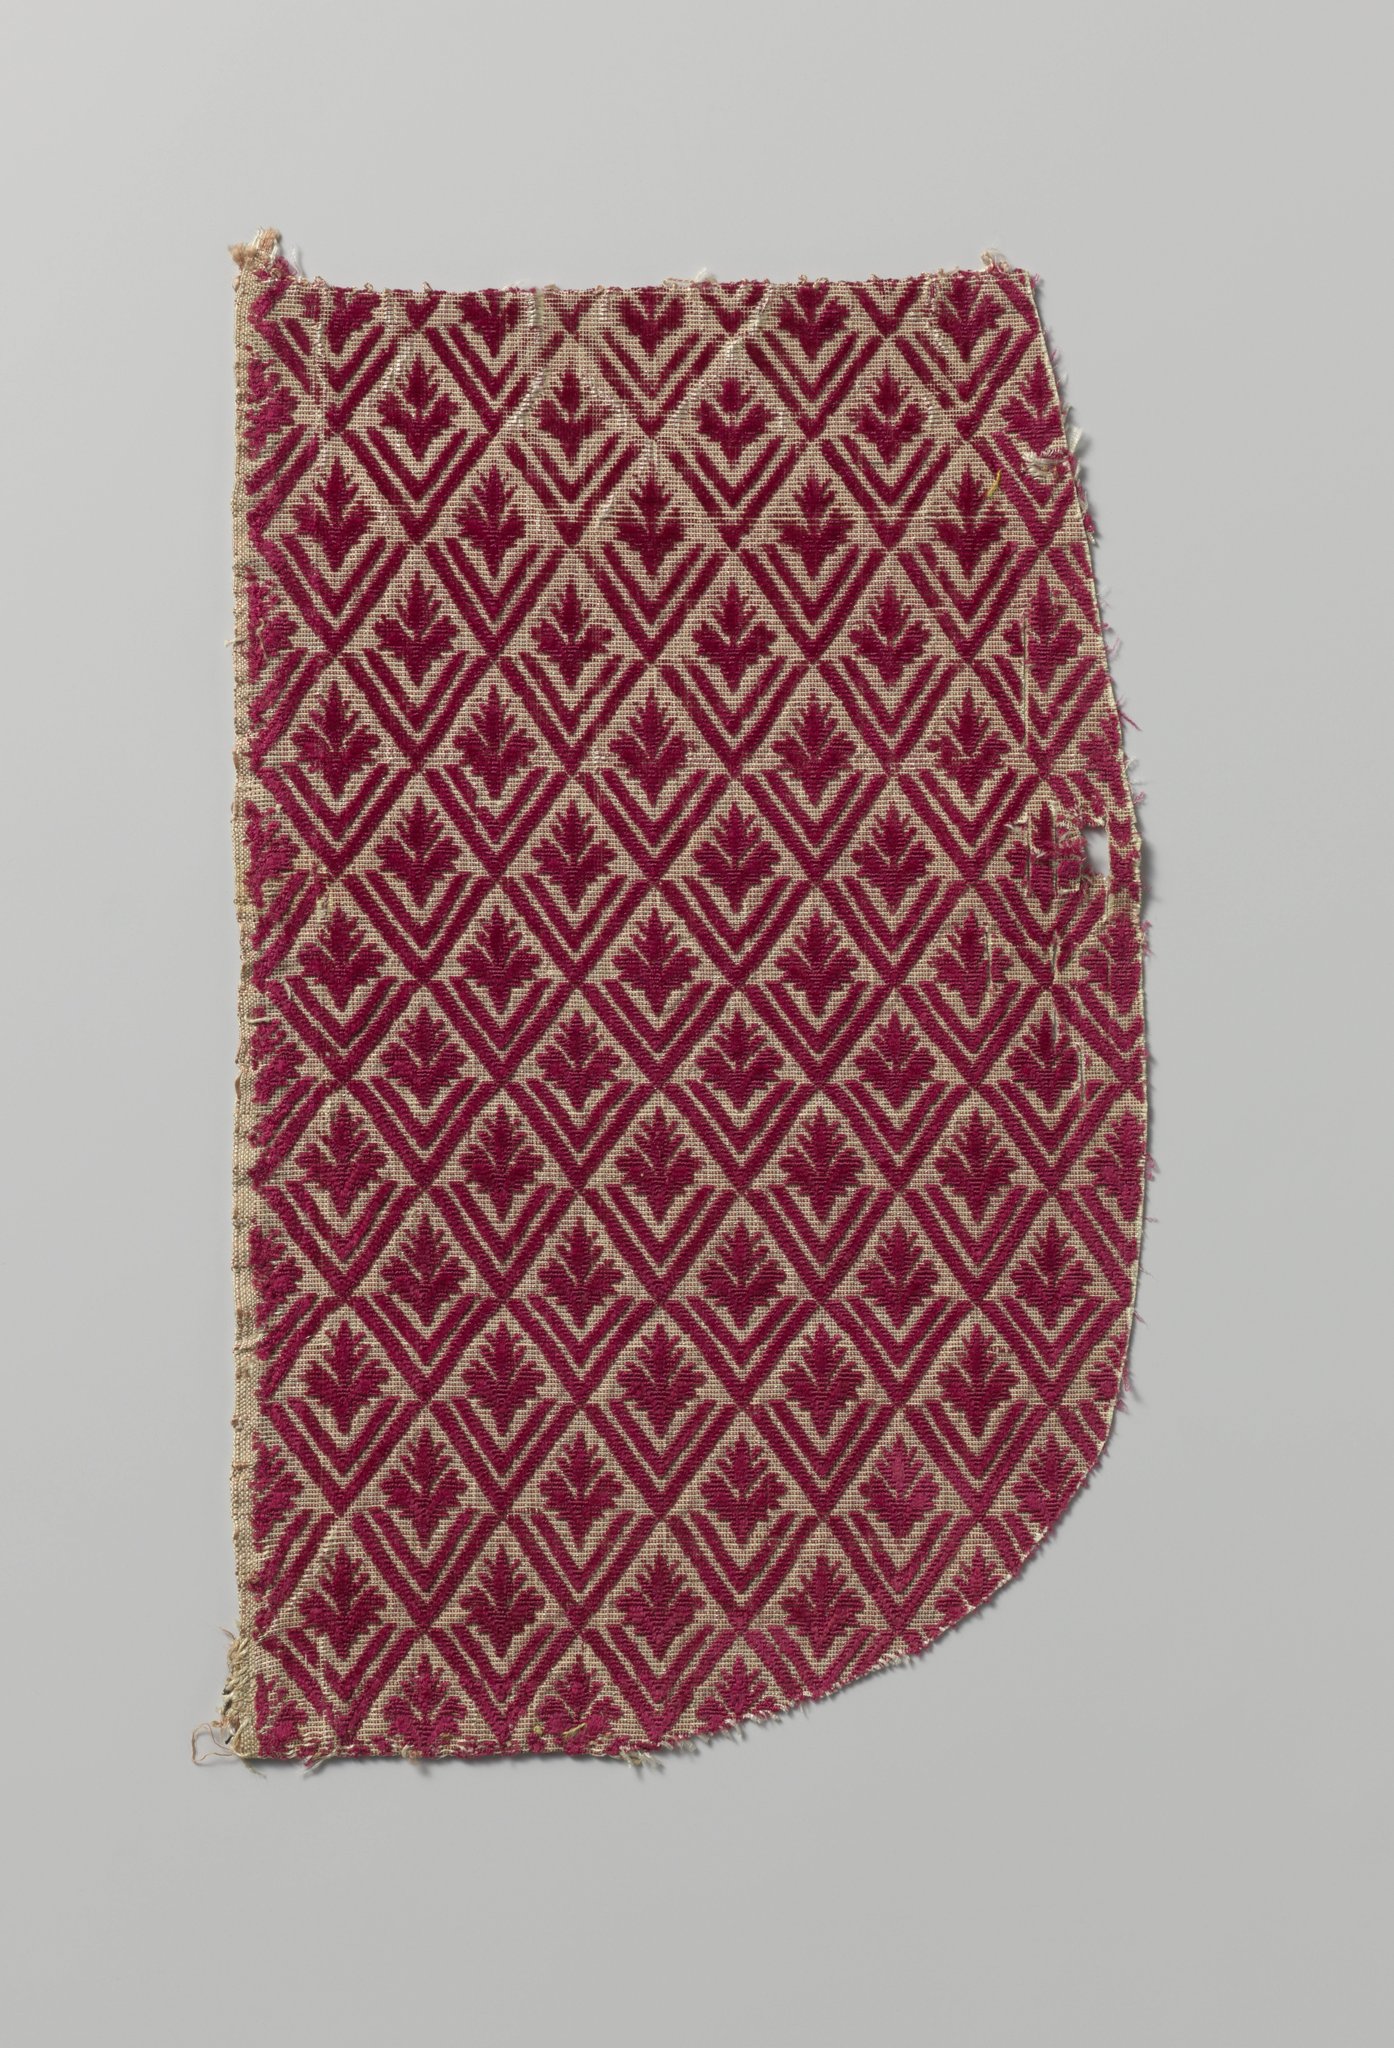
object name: zijdefluweel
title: Fragment zijdefluweel met ruitwerk en palmetten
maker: Anonymous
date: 1500-1599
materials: metal thread, silk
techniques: velvet, weave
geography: italy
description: Fragment rood zijdefluweel met op wit fond door hoeken gevormd ruitwerk waarbinnen palmetten.